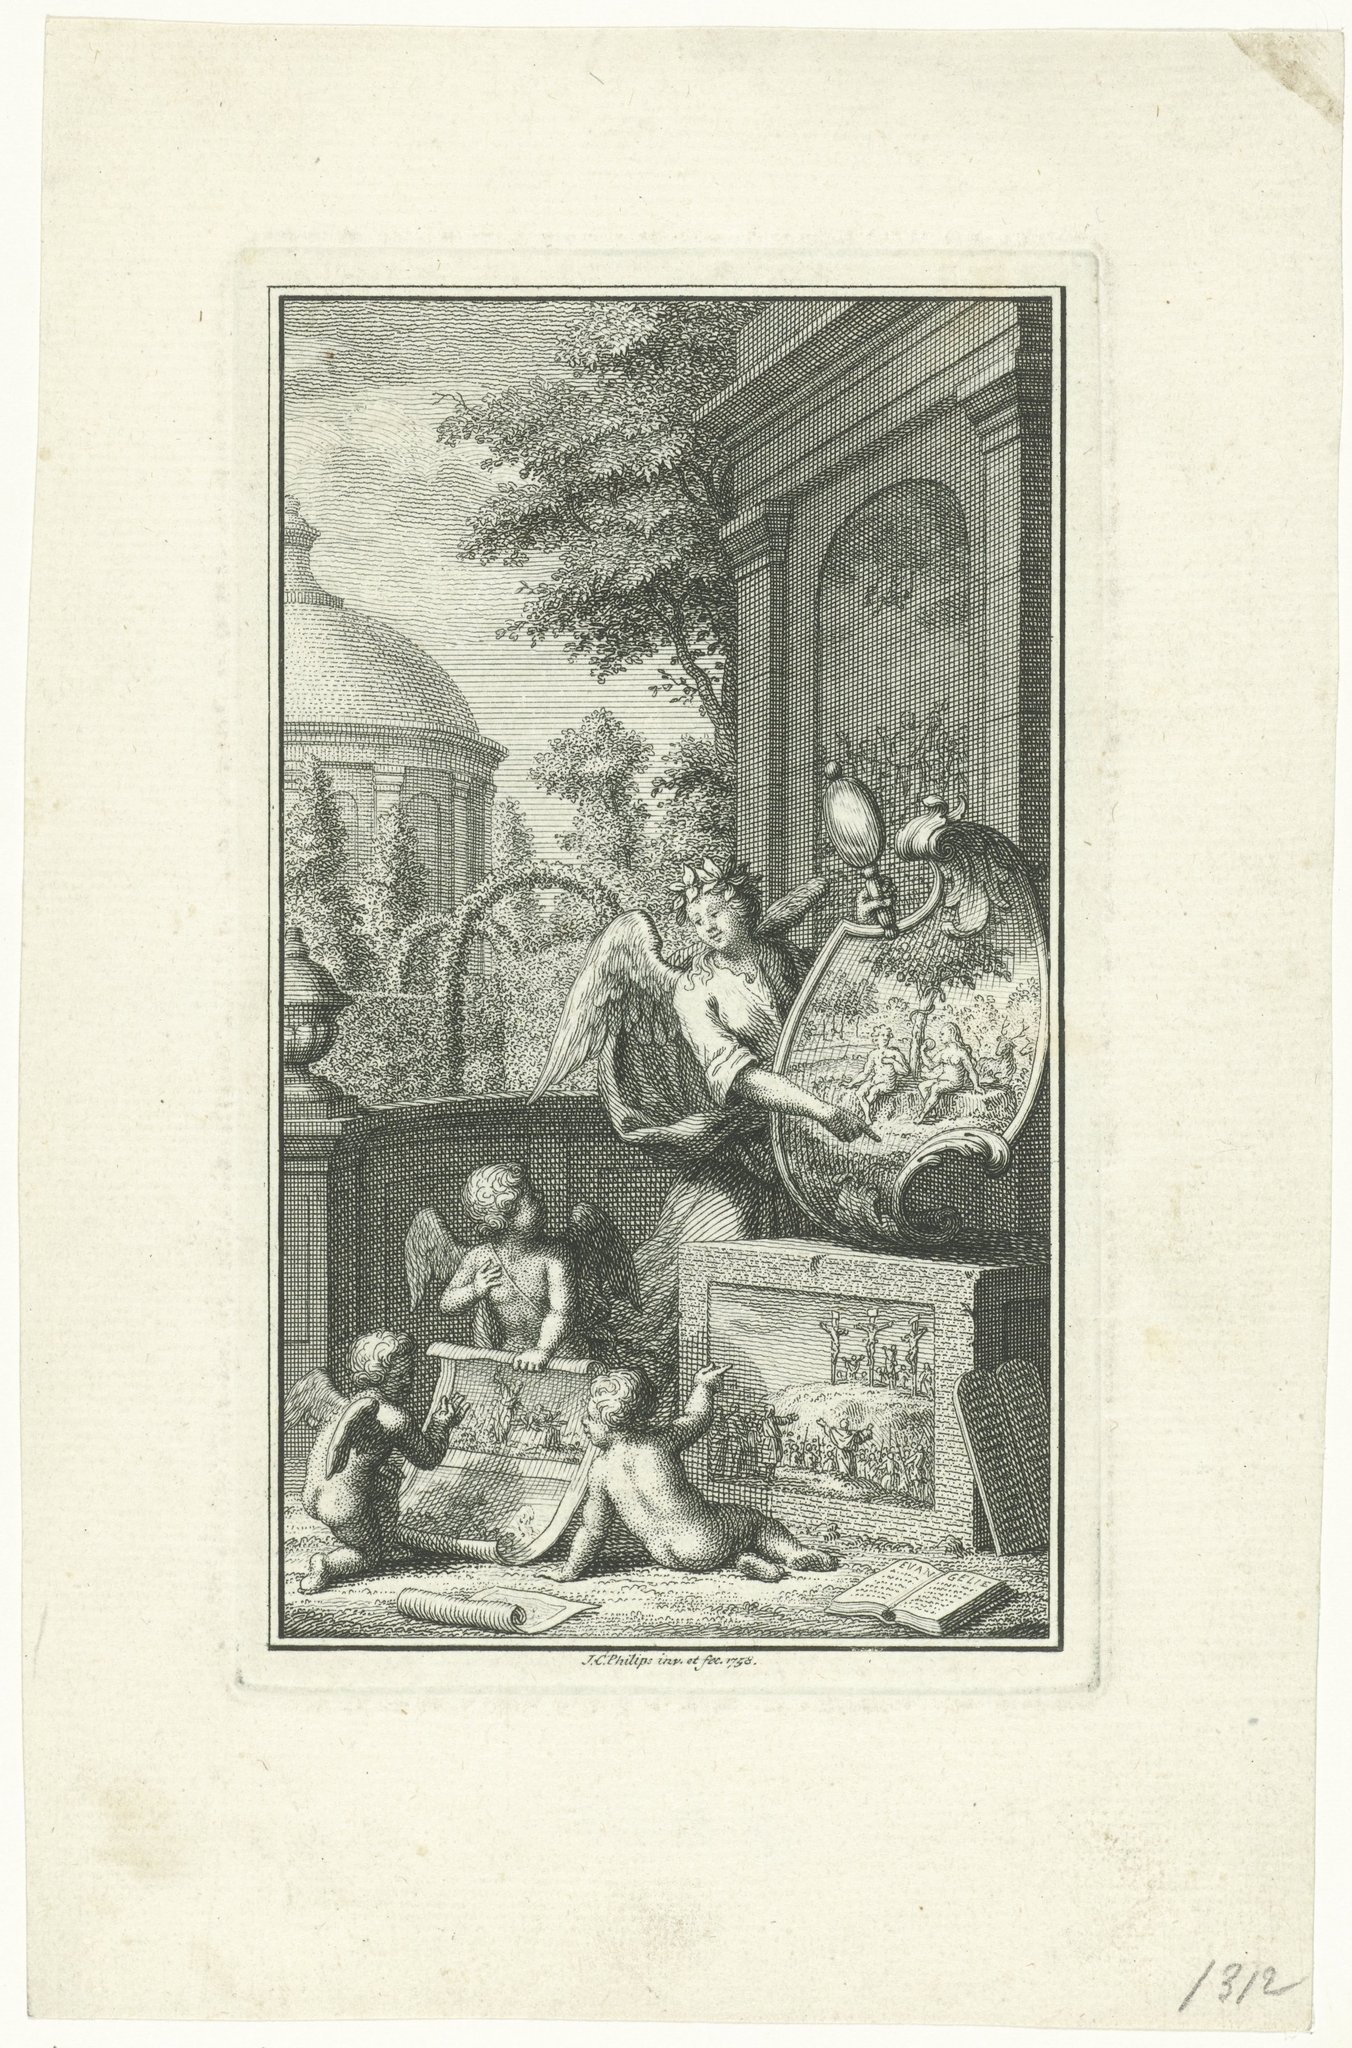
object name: print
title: Voorzichtigheid wijst op wapenschild met de zondeval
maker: jan caspar philips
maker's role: draughtsman, print maker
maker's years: 1700-1775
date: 1758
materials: paper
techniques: engraving, etching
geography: amsterdam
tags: eve offers the fruit to adam, the sacrifice of isaac (genesis 22), the crucifixion of christ: christ's death on the cross; golgotha (matthew 27:45-58; mark 15:33-45; luke 23:44-52; john 19:25-38), the bible as a book, prudentia (prudence) as roman personification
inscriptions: collector's mark: Lugt 2228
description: Voorzichtigheid (Prudentia) wijst op een wapenschild waarop de zondeval is voorgesteld. Op de voorgrond drie putti met een vel papier waarop het offer van Abraham is afgebeeld. Eén van hen wijst op een piëdestal waarop de kruisiging. Rechts op de voorgrond een opengeslagen bijbel.